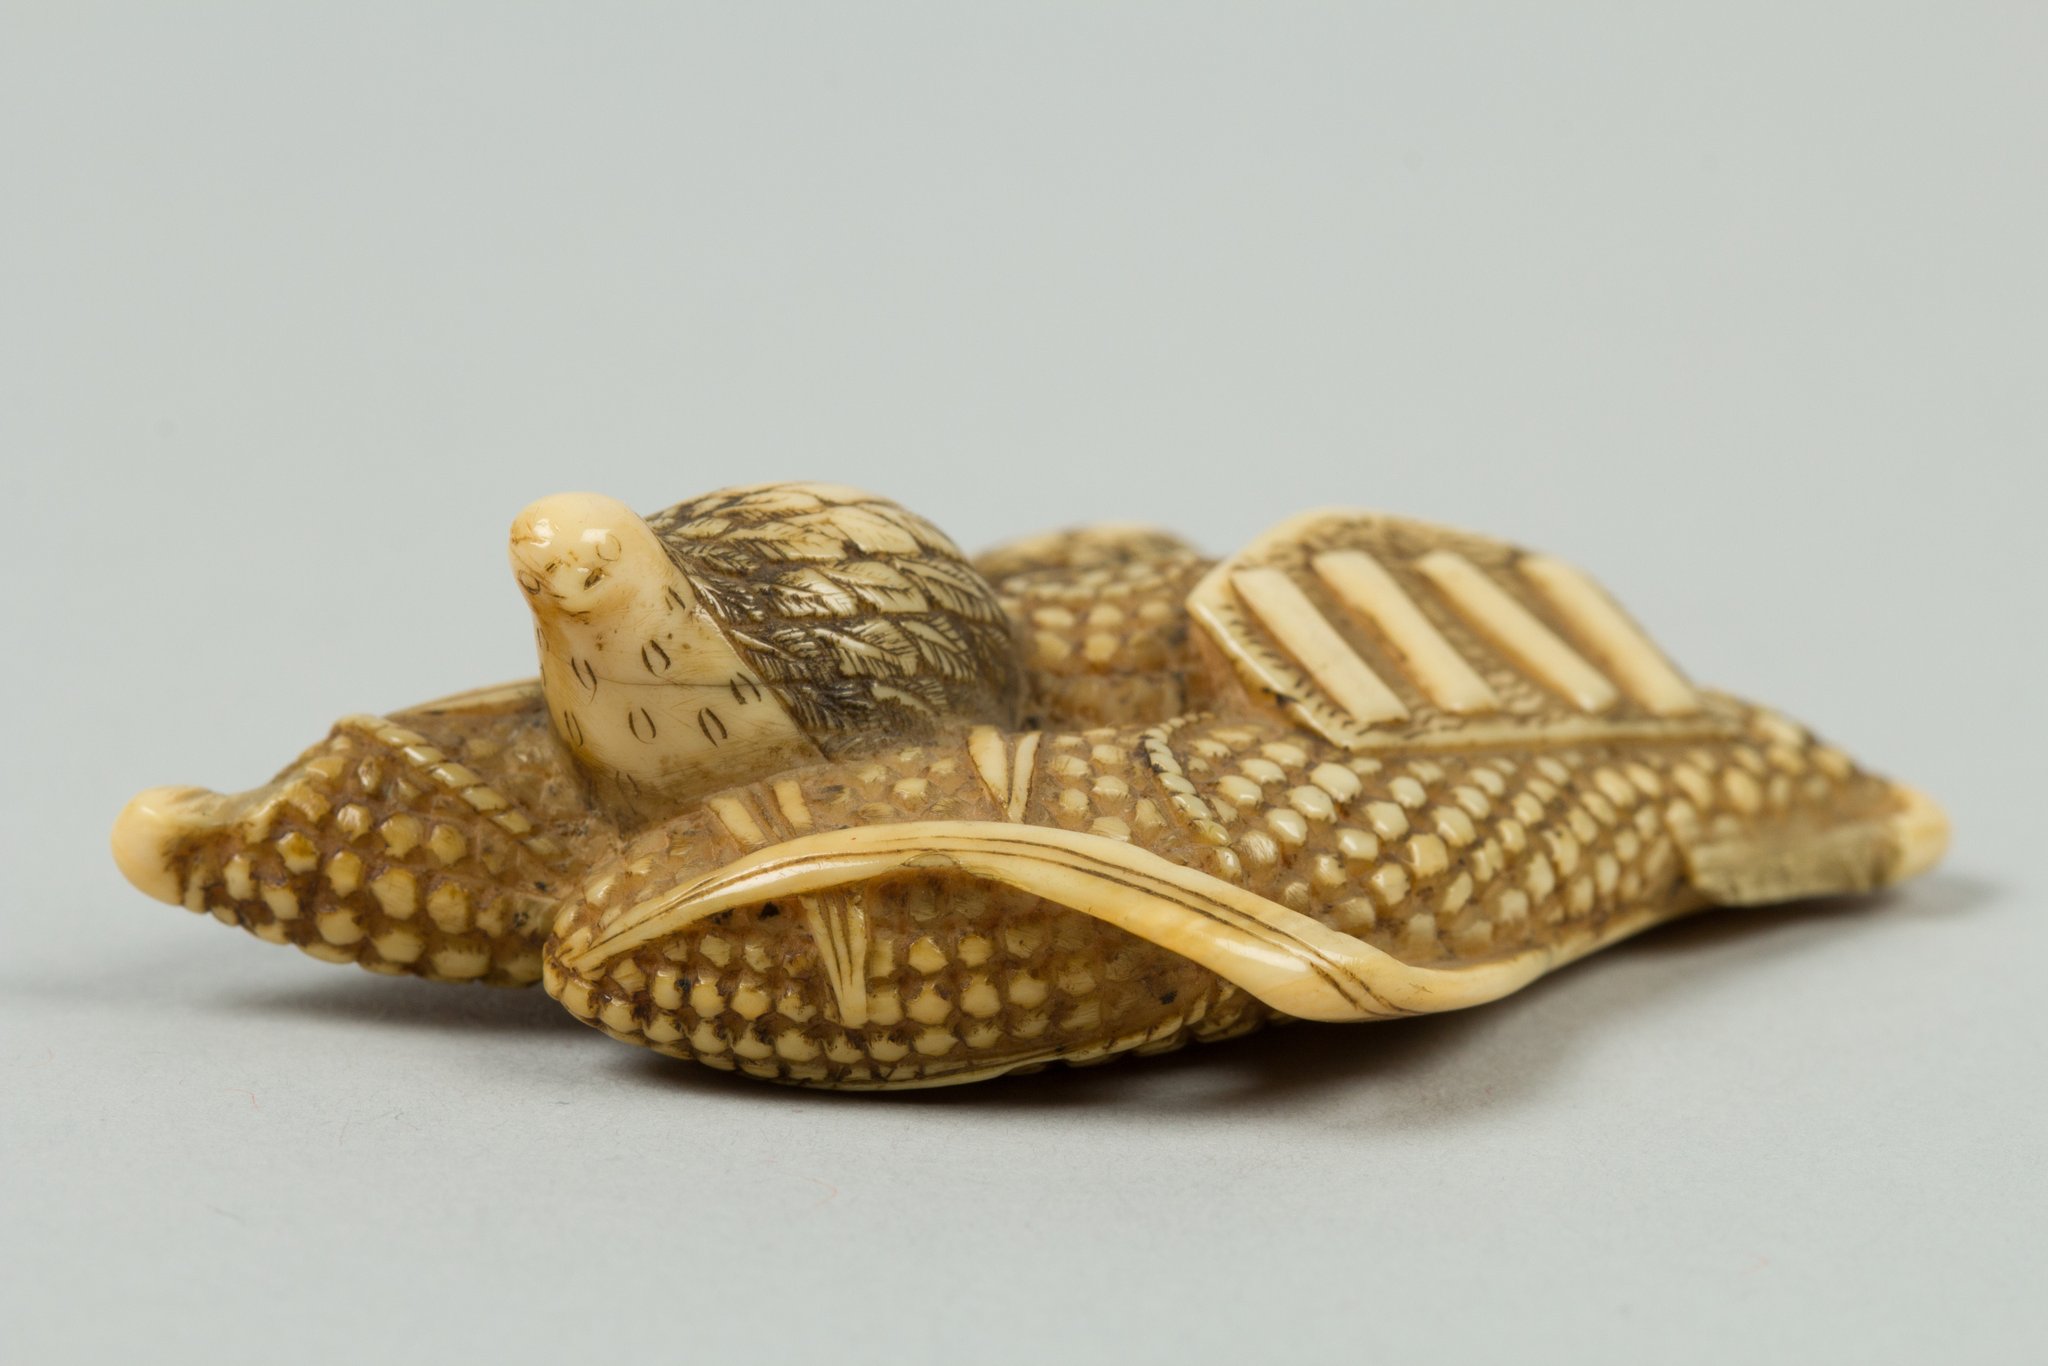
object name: netsuke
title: Netsuke of Birds and Corn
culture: japanese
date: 1801-1900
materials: ivory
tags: vegetables